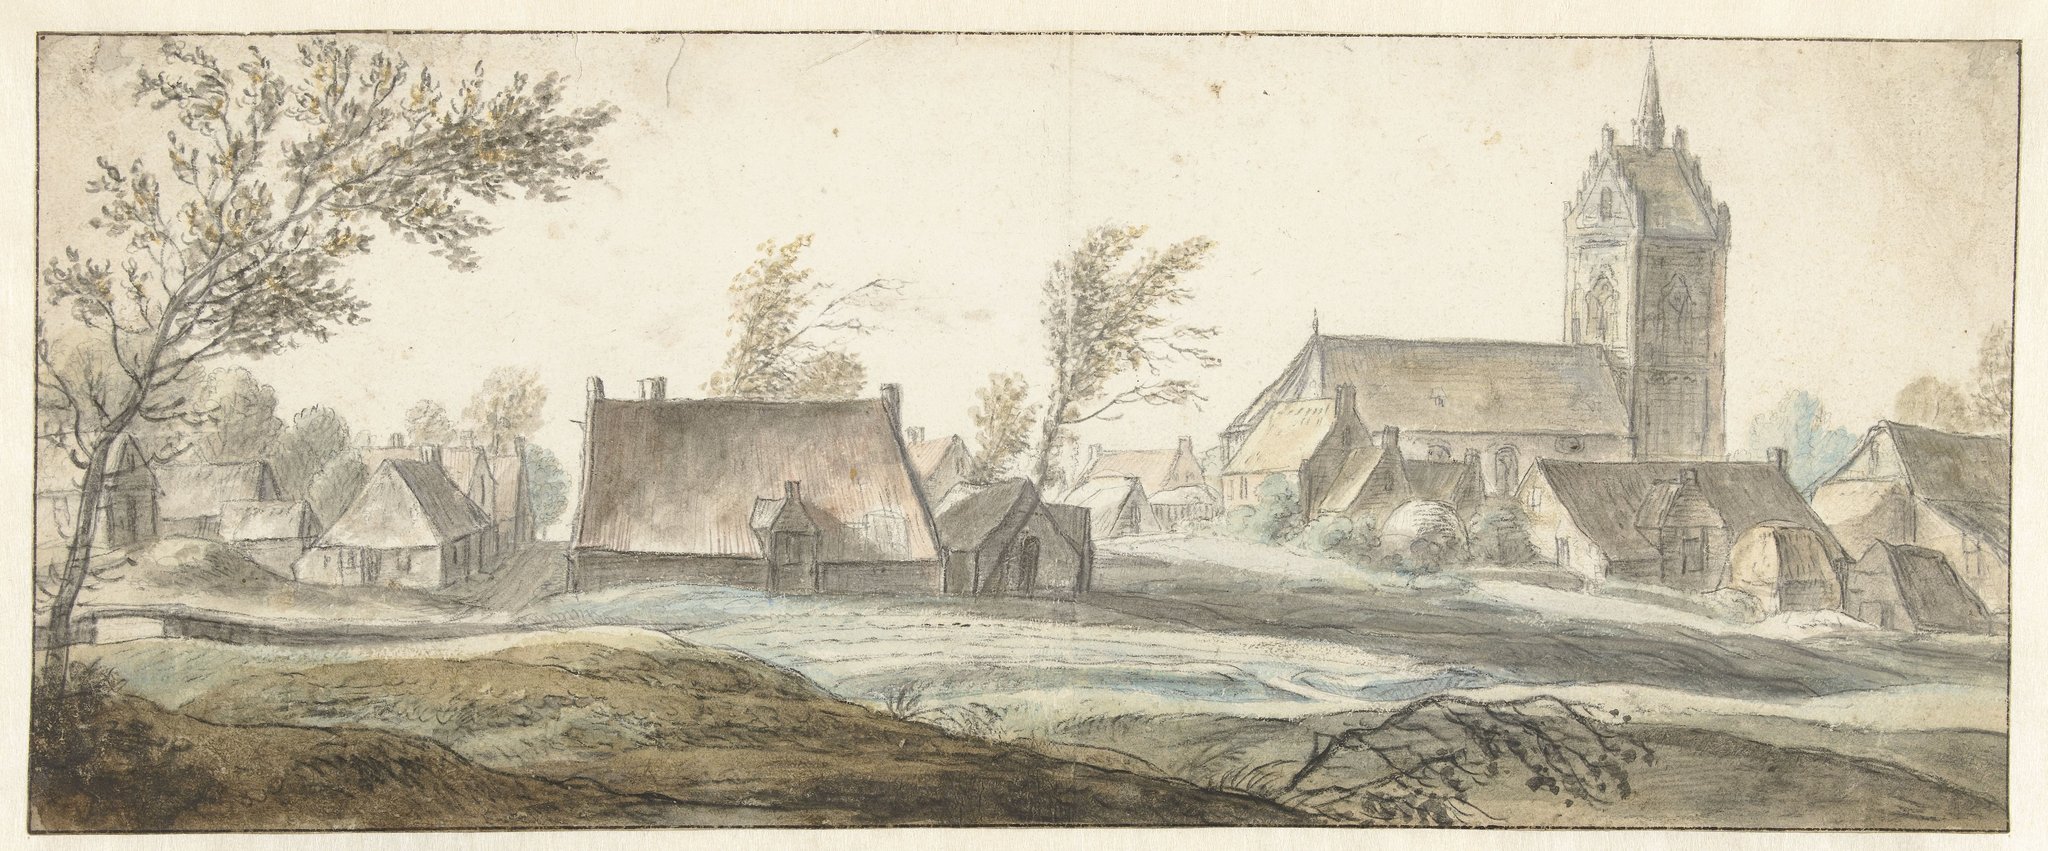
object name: drawing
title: Gezicht op het dorp Soest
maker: anthonie waterloo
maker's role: draughtsman, painter, print maker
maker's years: 1609-1690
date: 1619-1690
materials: paper, watercolor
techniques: brush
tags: prospect of village, silhouette of village